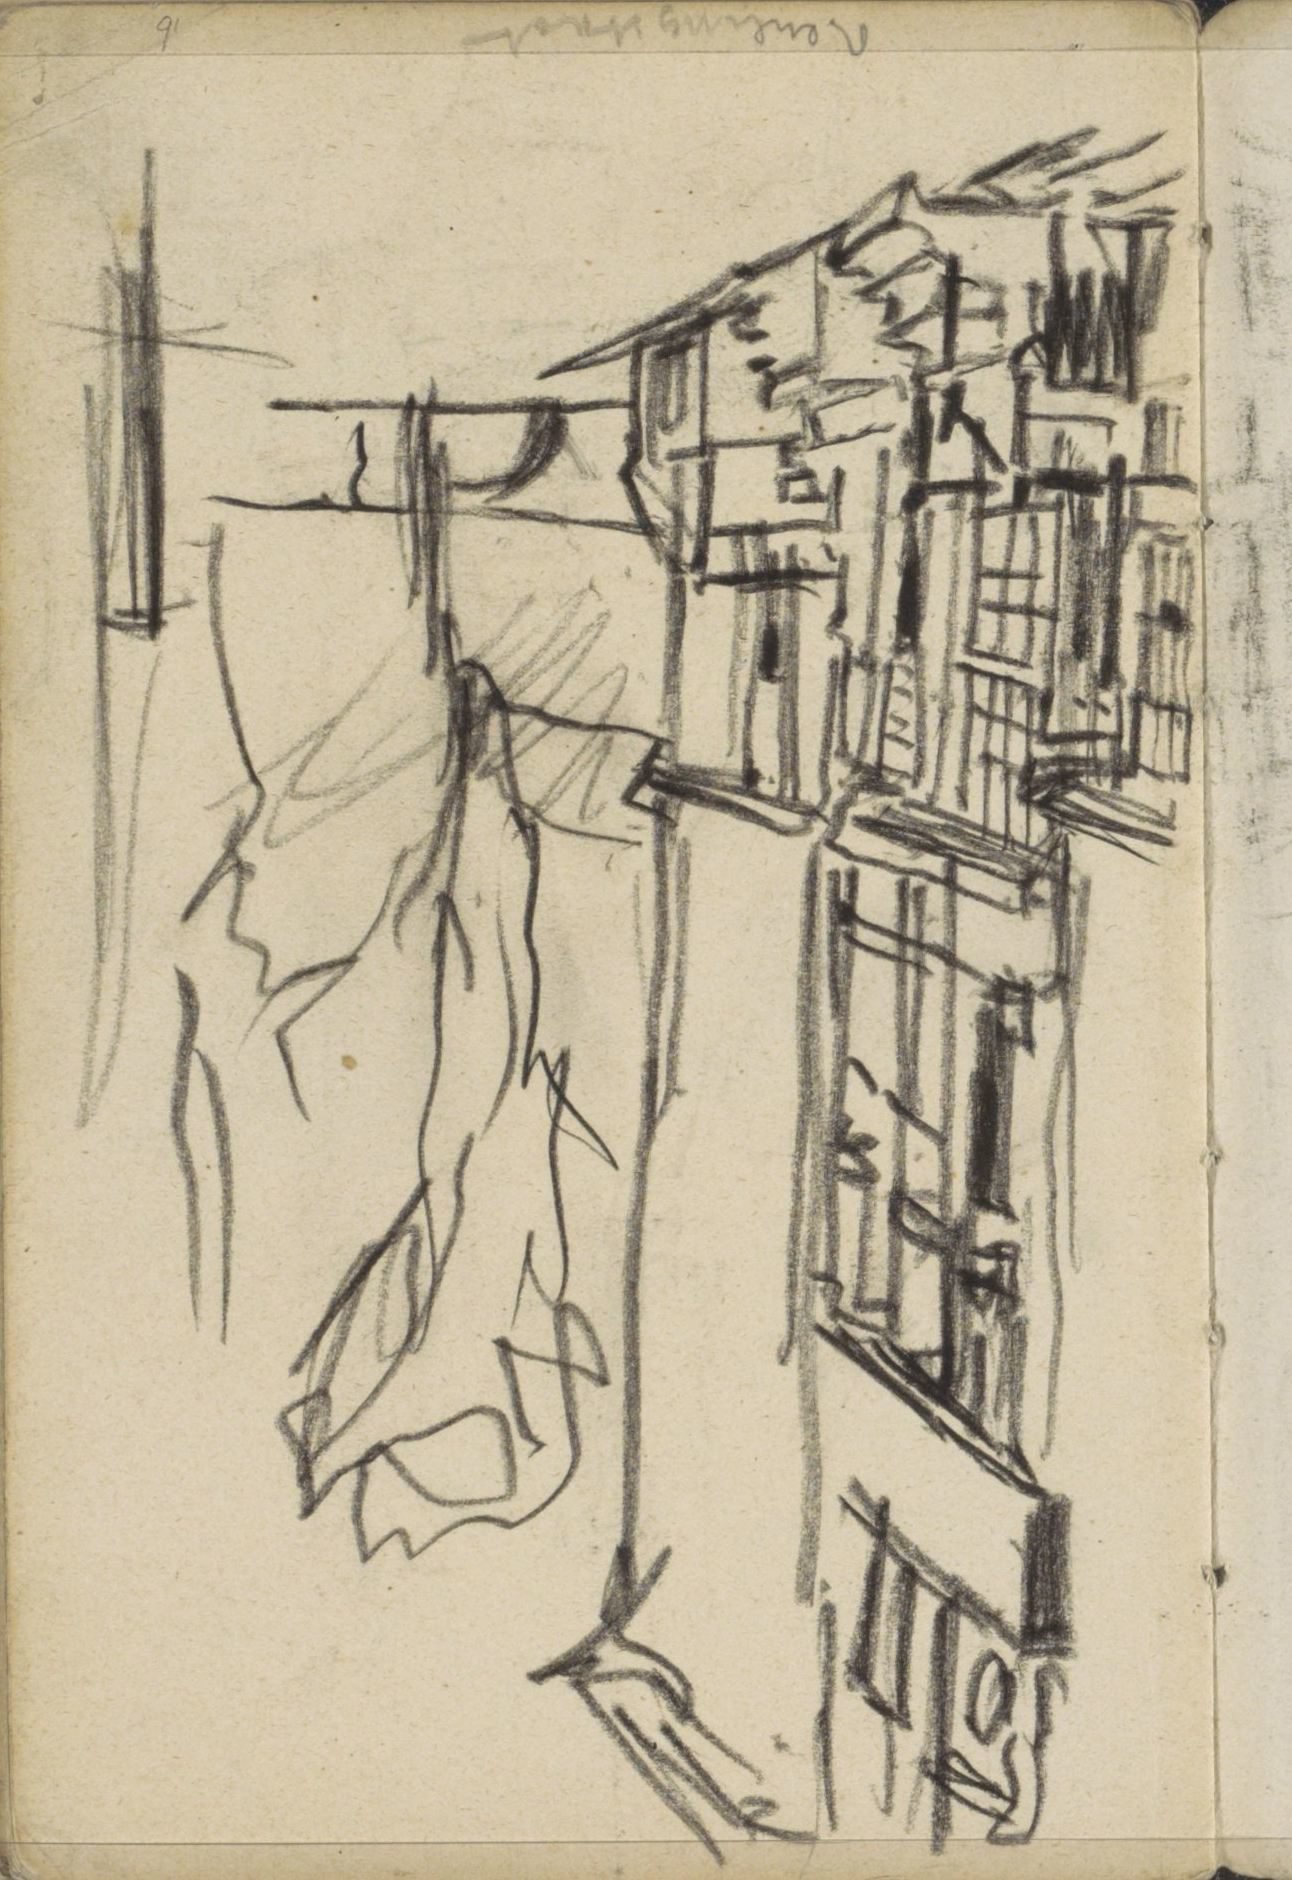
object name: sketchbook leaf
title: Gezicht op de Beulingstraat te Amsterdam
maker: george hendrik breitner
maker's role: draughtsman, painter, print maker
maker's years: 1857-1923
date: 1903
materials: chalk, paper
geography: amsterdam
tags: urban housing, street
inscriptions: annotation: ‘Beulingstraat’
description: Gezicht op de Beulingstraat te Amsterdam. Pagina 91 uit een schetsboek met 46 bladen vervaardigd te Amsterdam en Haarlem.